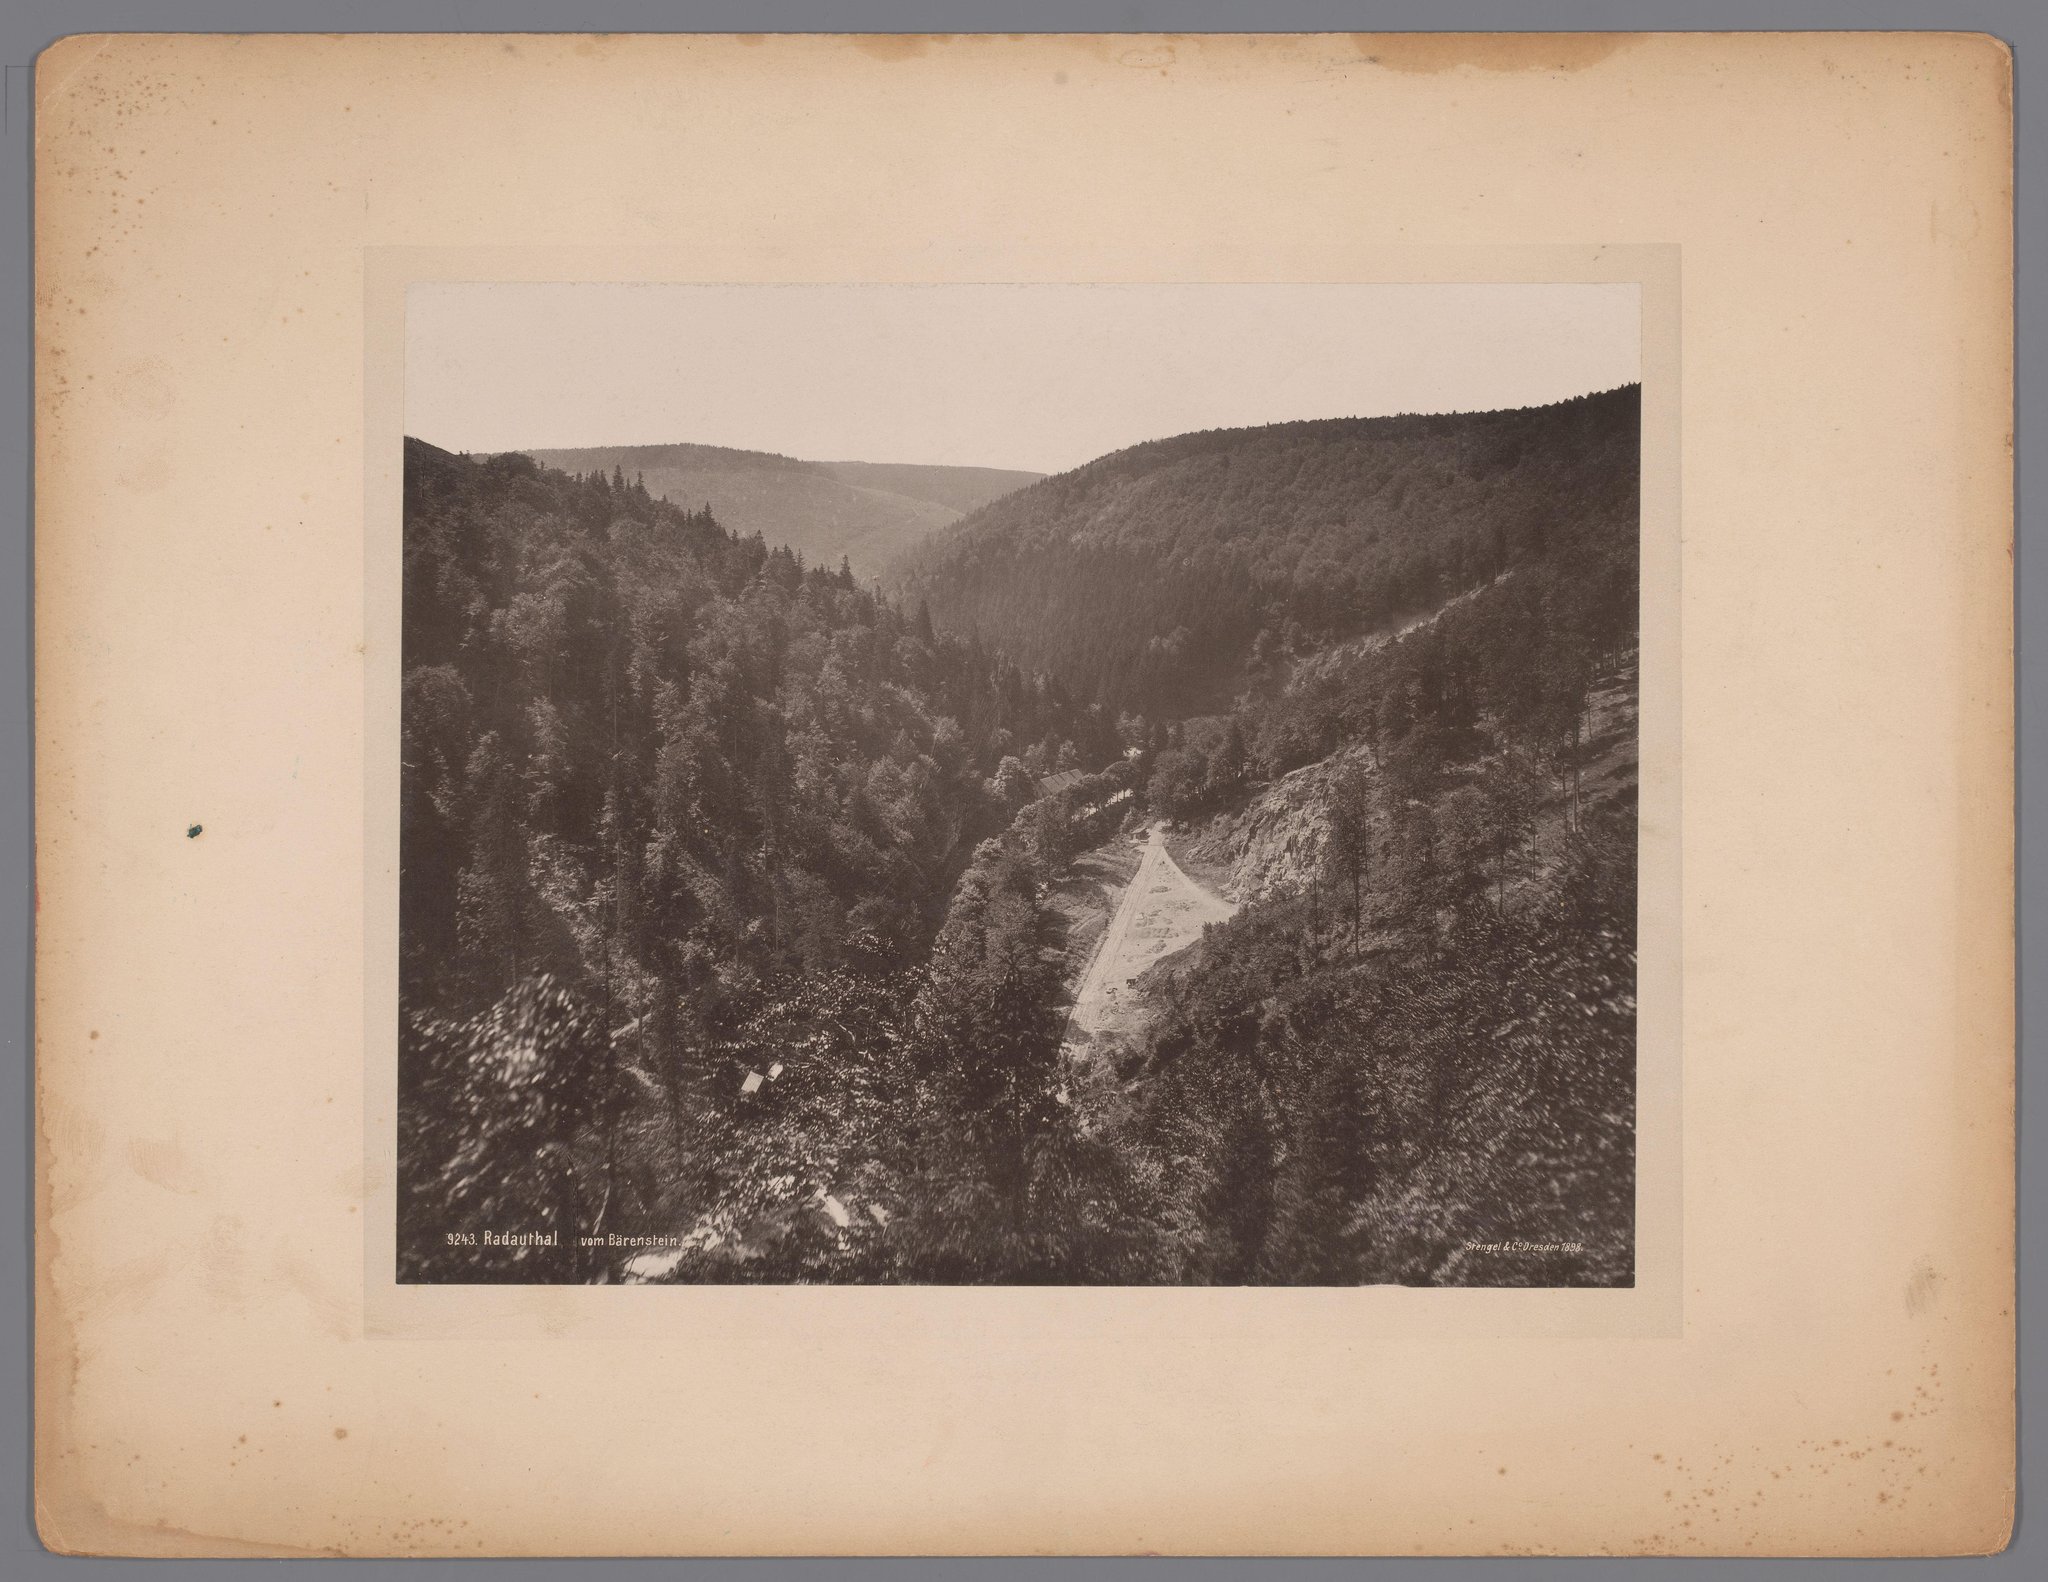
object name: photograph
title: "Radauthal vom Bärenstein", Harz, Duitsland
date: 1898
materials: paper, photographic support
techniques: photoaquatint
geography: germany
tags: harz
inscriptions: number: ‘13.’, inscription: ‘Stengel & Co., Dresden 1898.’, inscription: ‘3243. Radauthal vom Bärenstein’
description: Gezicht op het Radauthal vanuit een hoog standpunt, 'vanaf Bärenstein'. Bärenstein is een plaats in de Duitse deelstaat Saksen, en maakt deel uit van het district Erzgebirgskreis. Het opschrift 'vom Bärenstein' doet echter vermoeden dat het om een berg/rots gaat.